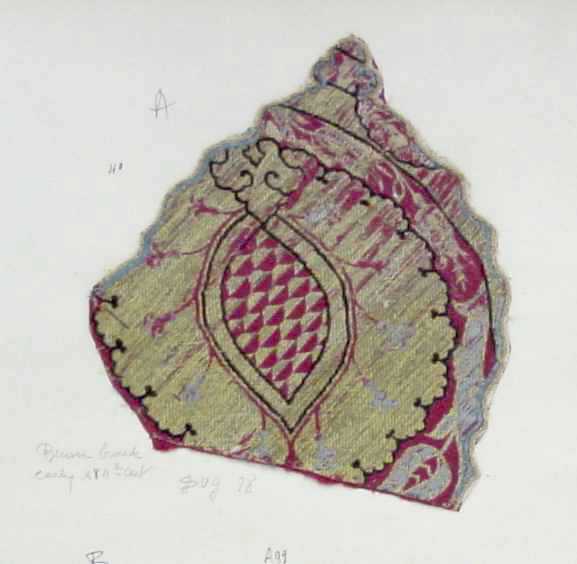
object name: textile fragment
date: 1601-1633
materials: metal thread, silk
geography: turkey